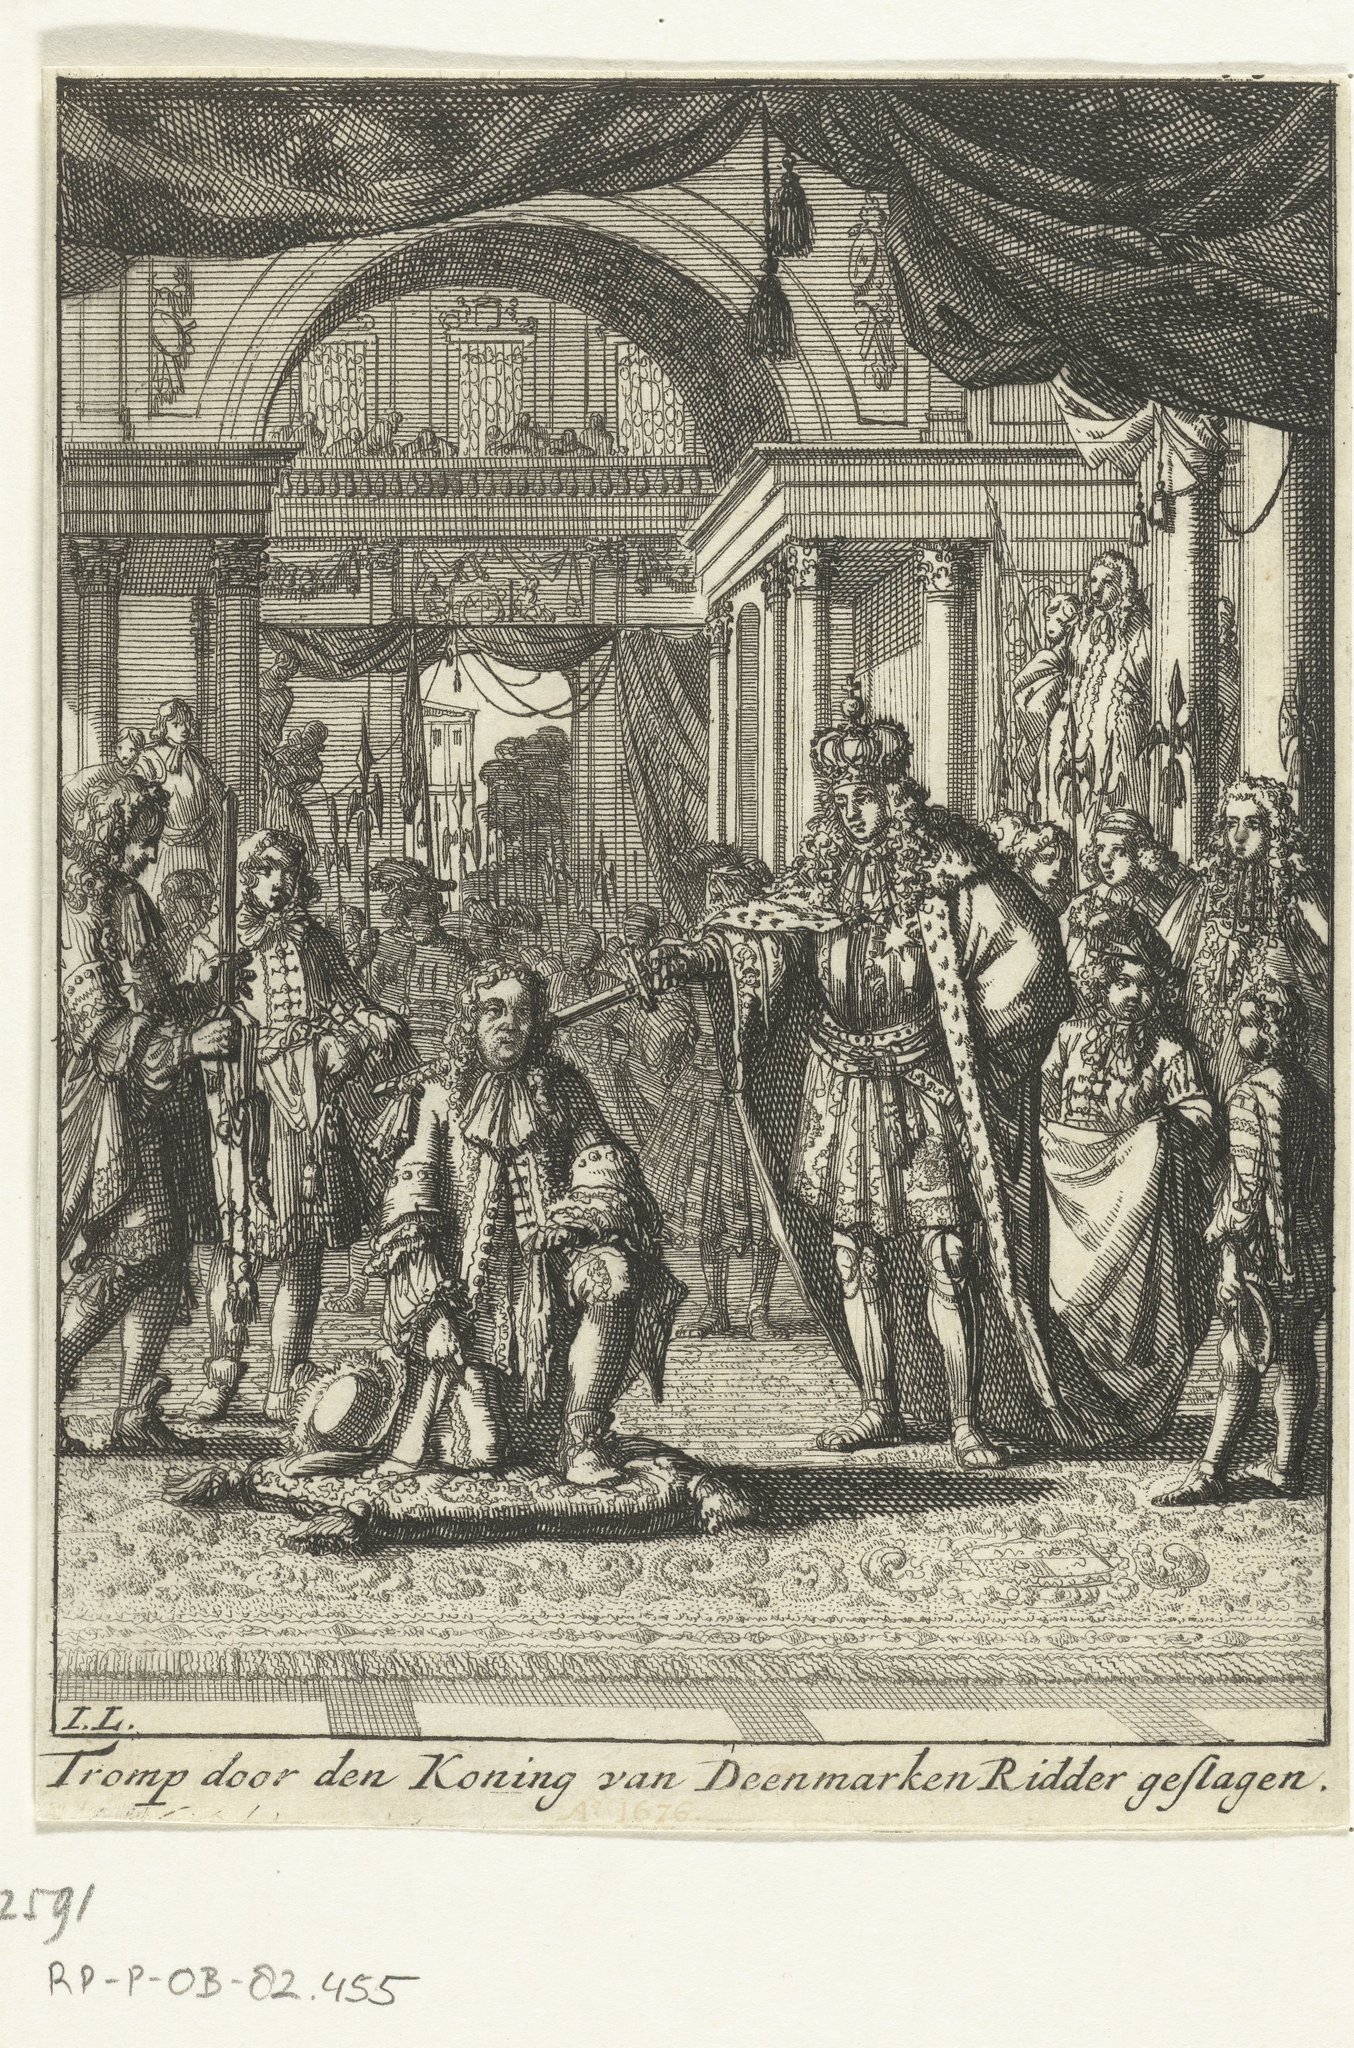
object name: history print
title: Cornelis Tromp door de koning van Denemarken tot Ridder geslagen, 1676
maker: jan luyken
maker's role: draughtsman, print maker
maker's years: 1649-1712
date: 1690-1692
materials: paper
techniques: etching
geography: northern netherlands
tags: amsterdam, cornelis tromp, knighting ceremonies, ruler bestowing nobility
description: Admiraal Cornelis Tromp wordt na de overwinning behaald door de gecombineerde Hollands-Deense vloot op de Zweedse vloot in de slag bij Öland op 11 juni 1676 door de koning Christiaan V van Denemarken tot ridder geslagen.